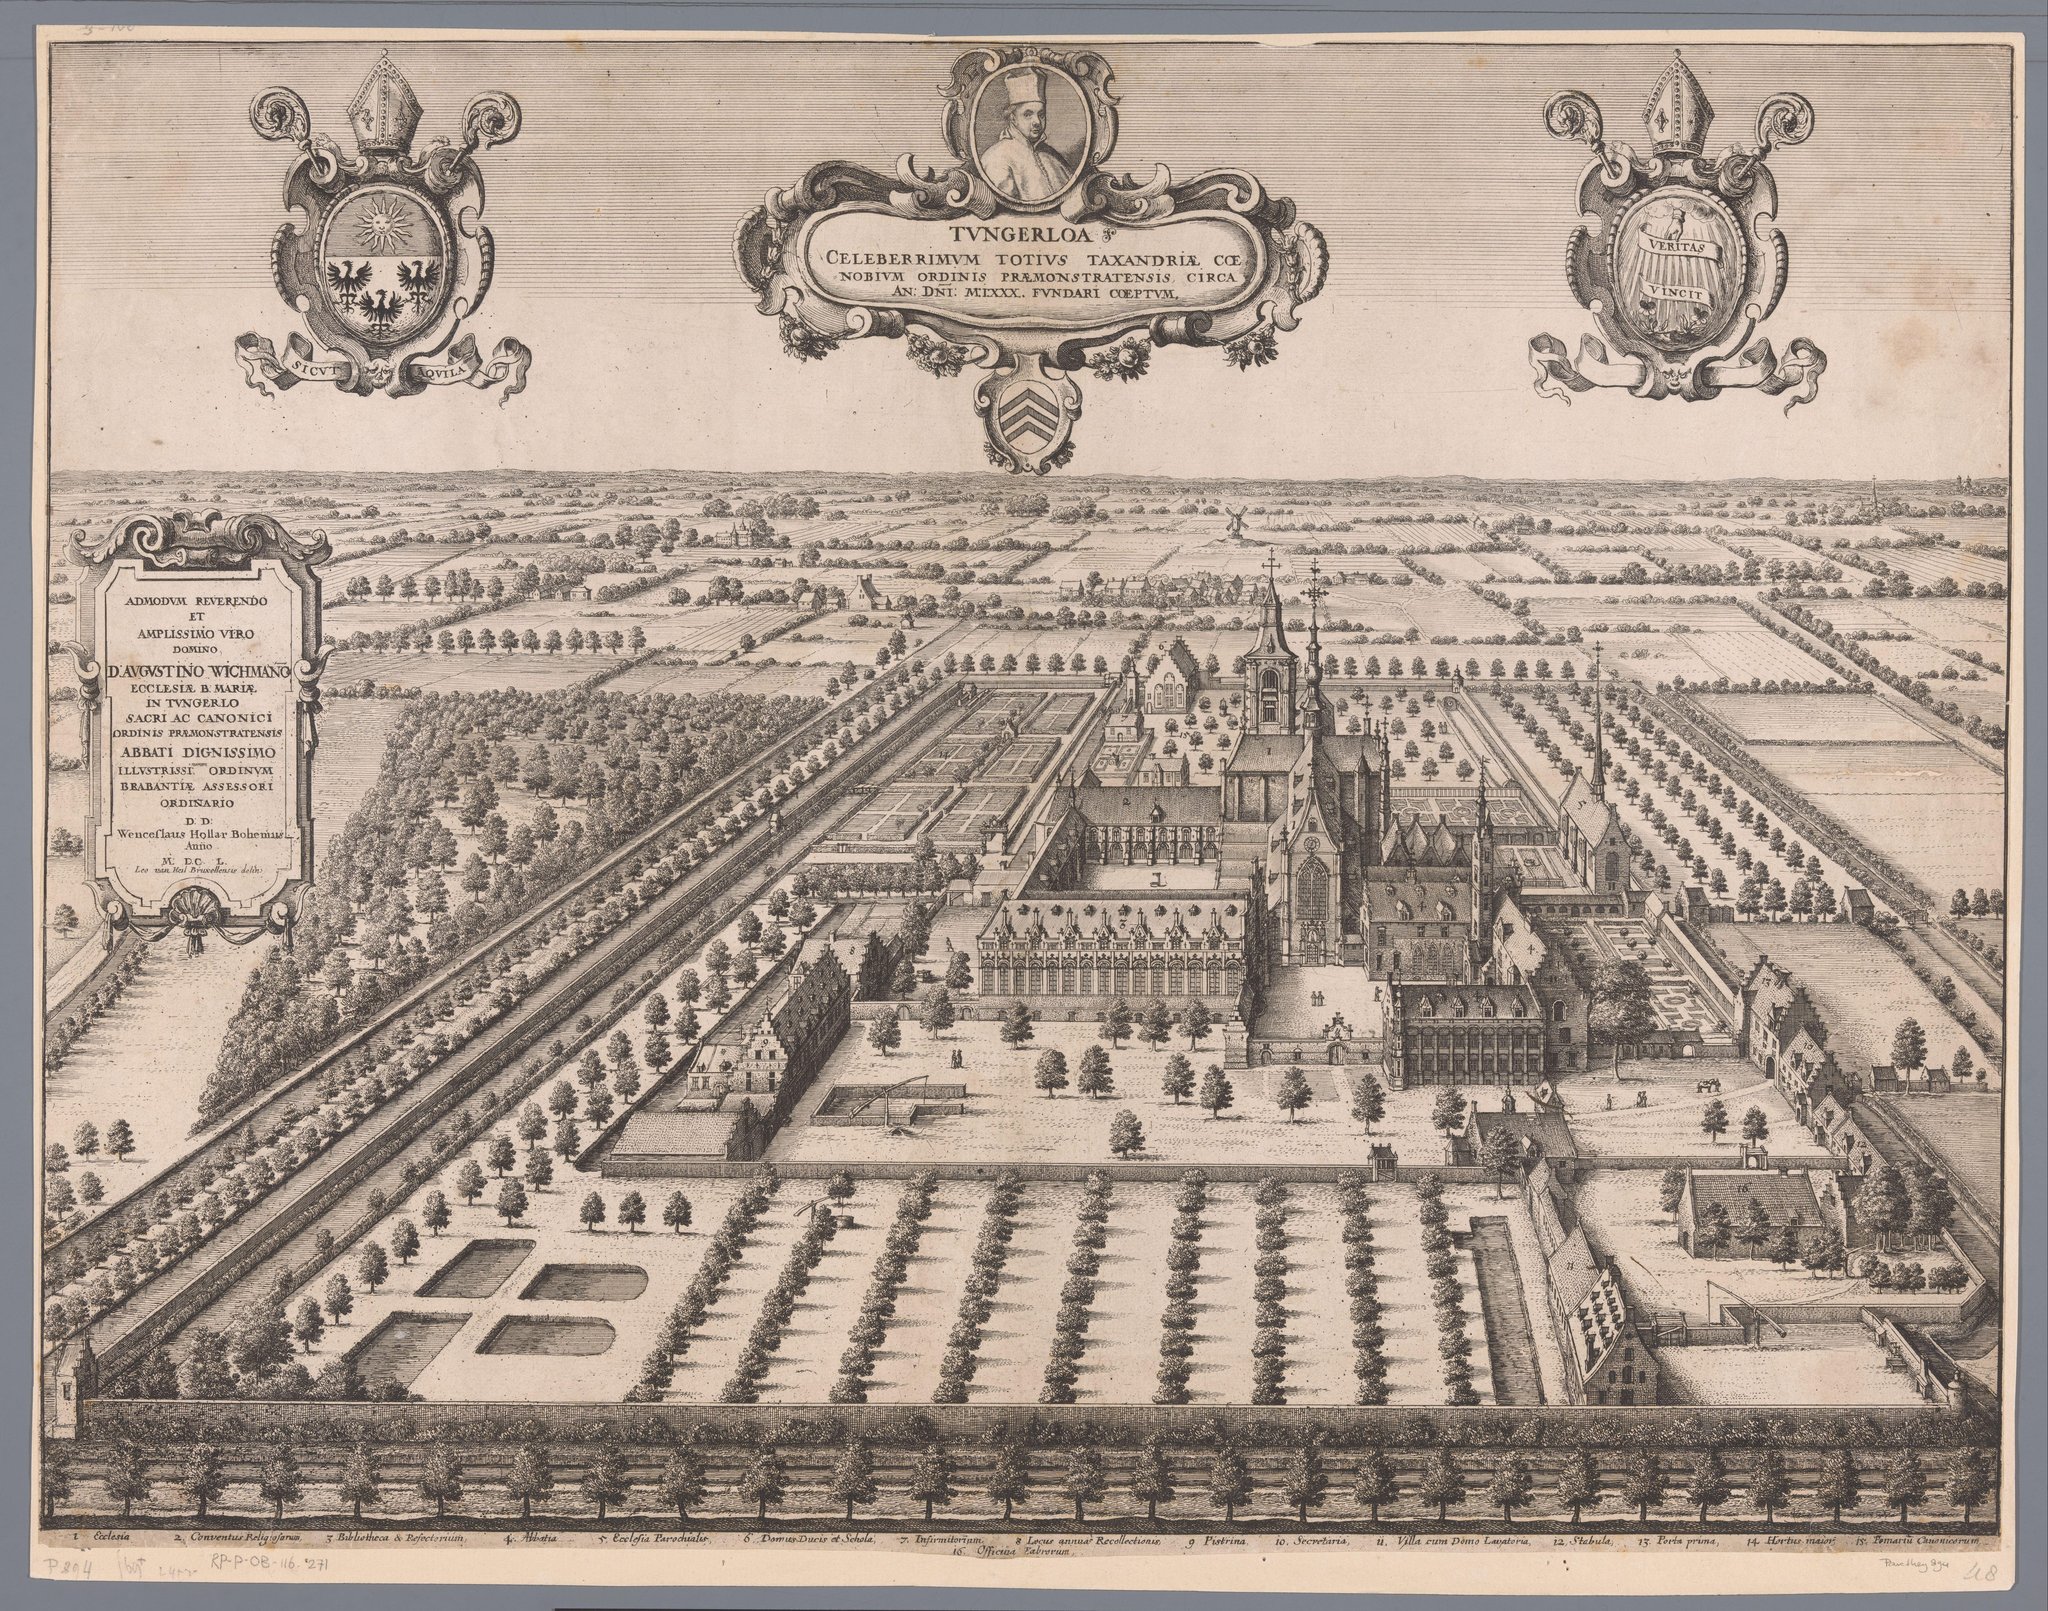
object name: print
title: Tongerloa (...)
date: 1650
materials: paper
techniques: drypoint, etching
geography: antwerp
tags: coat of arms (as symbol of the state, etc.), abbey, monastery, convent ~ roman catholic church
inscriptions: date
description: Links een cartouche met opdracht in het Latijn. Bovenin twee cartouches met wapenschilden en de titelcartouche. In de smalle marge onder de prent een legenda in het Latijn.